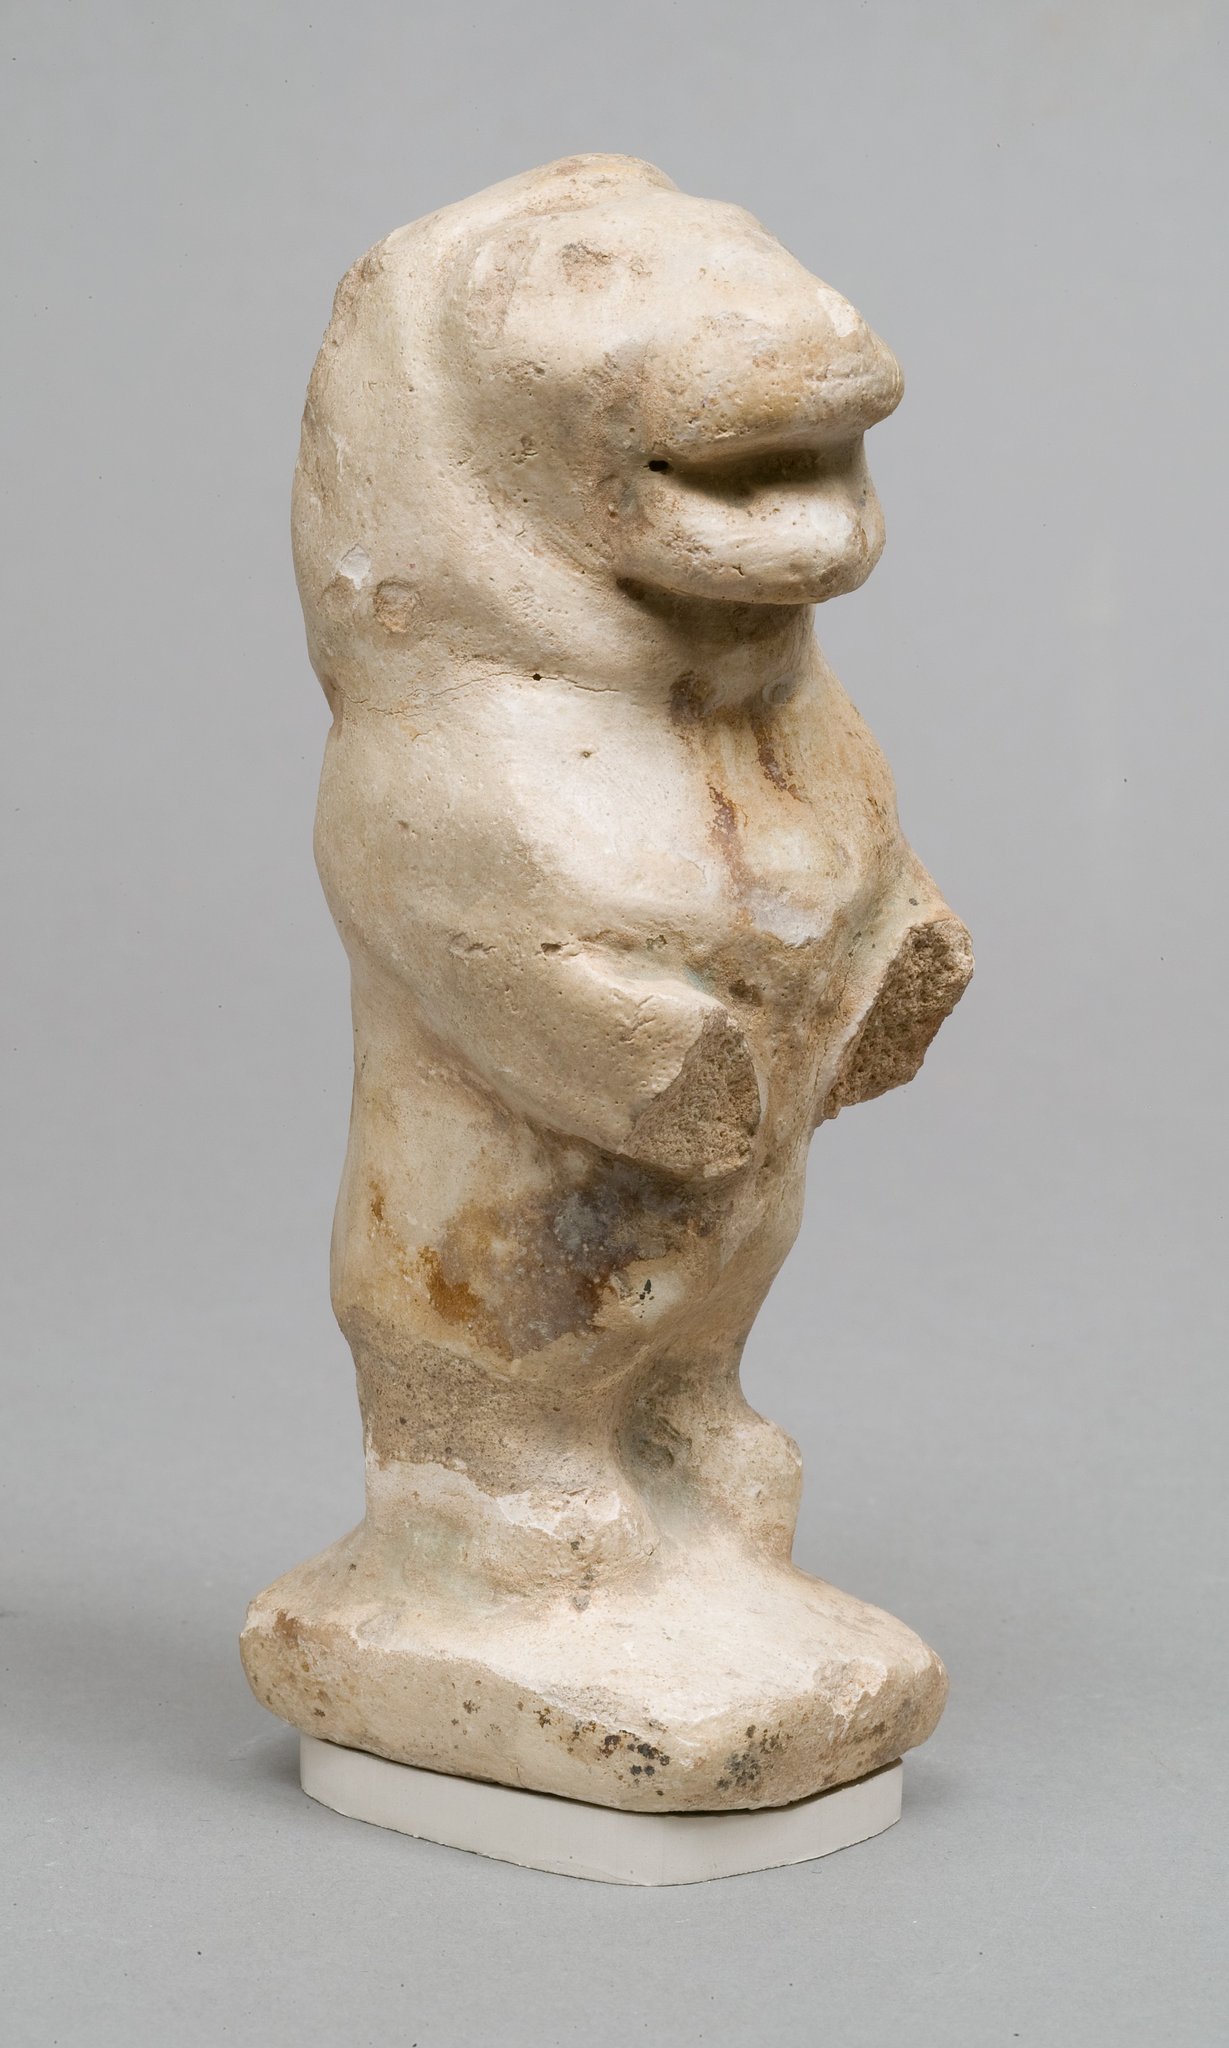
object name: figurine, lion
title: Lion figure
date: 1750 BCE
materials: faience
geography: egypt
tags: lions